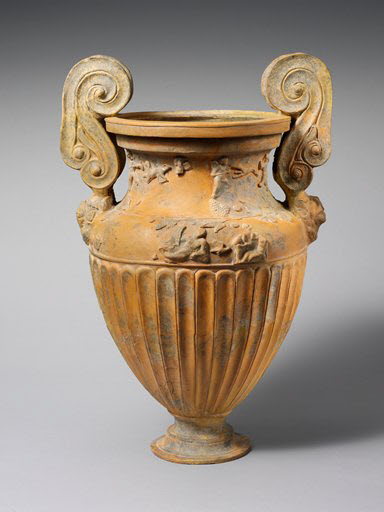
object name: volute krater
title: Terracotta volute-krater (container for mixing wine and water)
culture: etruscan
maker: bolsena group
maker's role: artist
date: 330-290 BCE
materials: terracotta